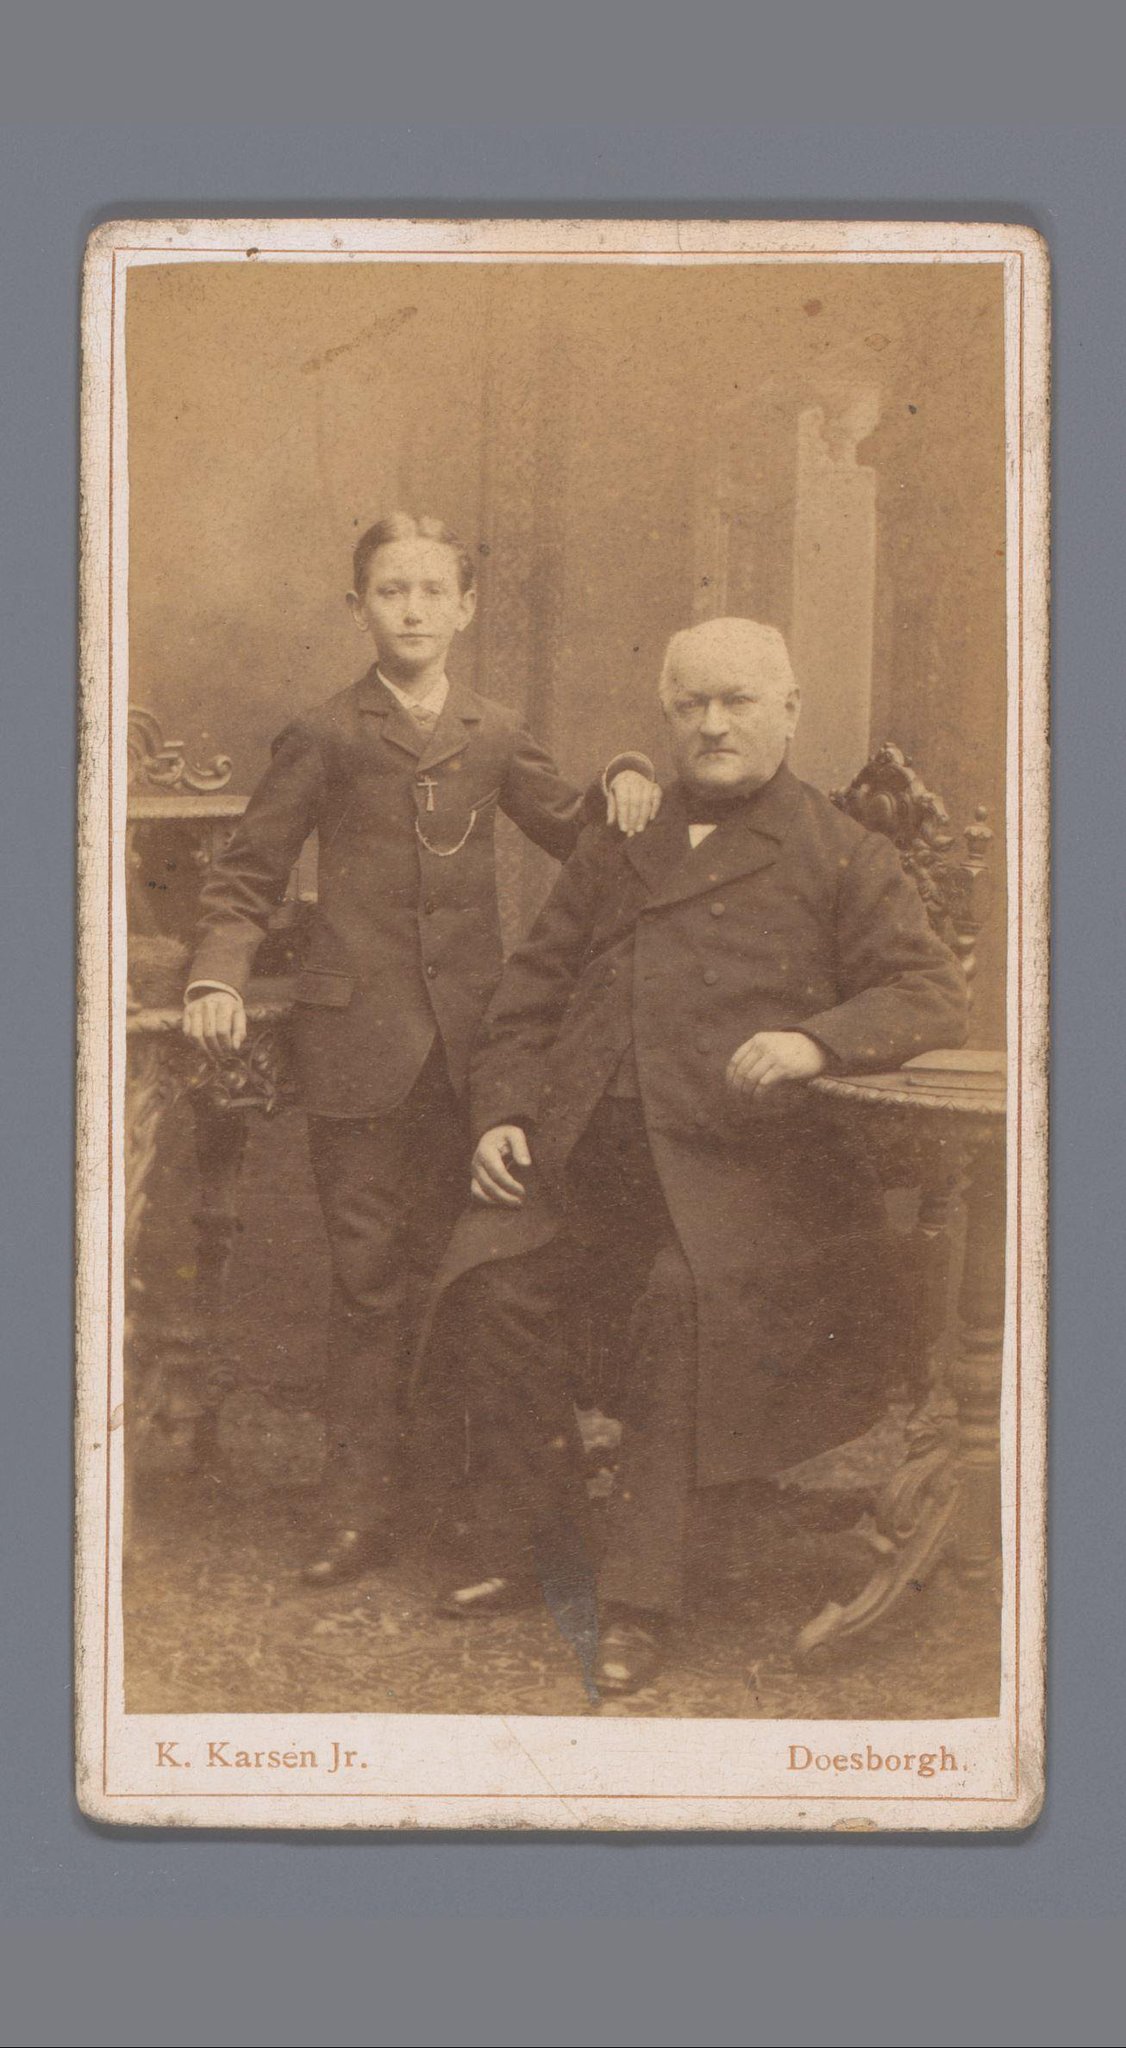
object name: photograph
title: Portret van een onbekende man en een onbekende jongen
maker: kars karsen jr.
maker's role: fotograaf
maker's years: 1852-1935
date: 1883-1906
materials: cardboard, paper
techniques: albumen print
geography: doesburg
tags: historical persons, father and son(s) (family group)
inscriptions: inscription: ‘K. KARSEN Jr./ PHOTOGRAAF/ Veerpoortstraat/ DOESBORGH/ Voor nabestelling worden alle/ negatieven bewaard./ Photographie Instantanée.’